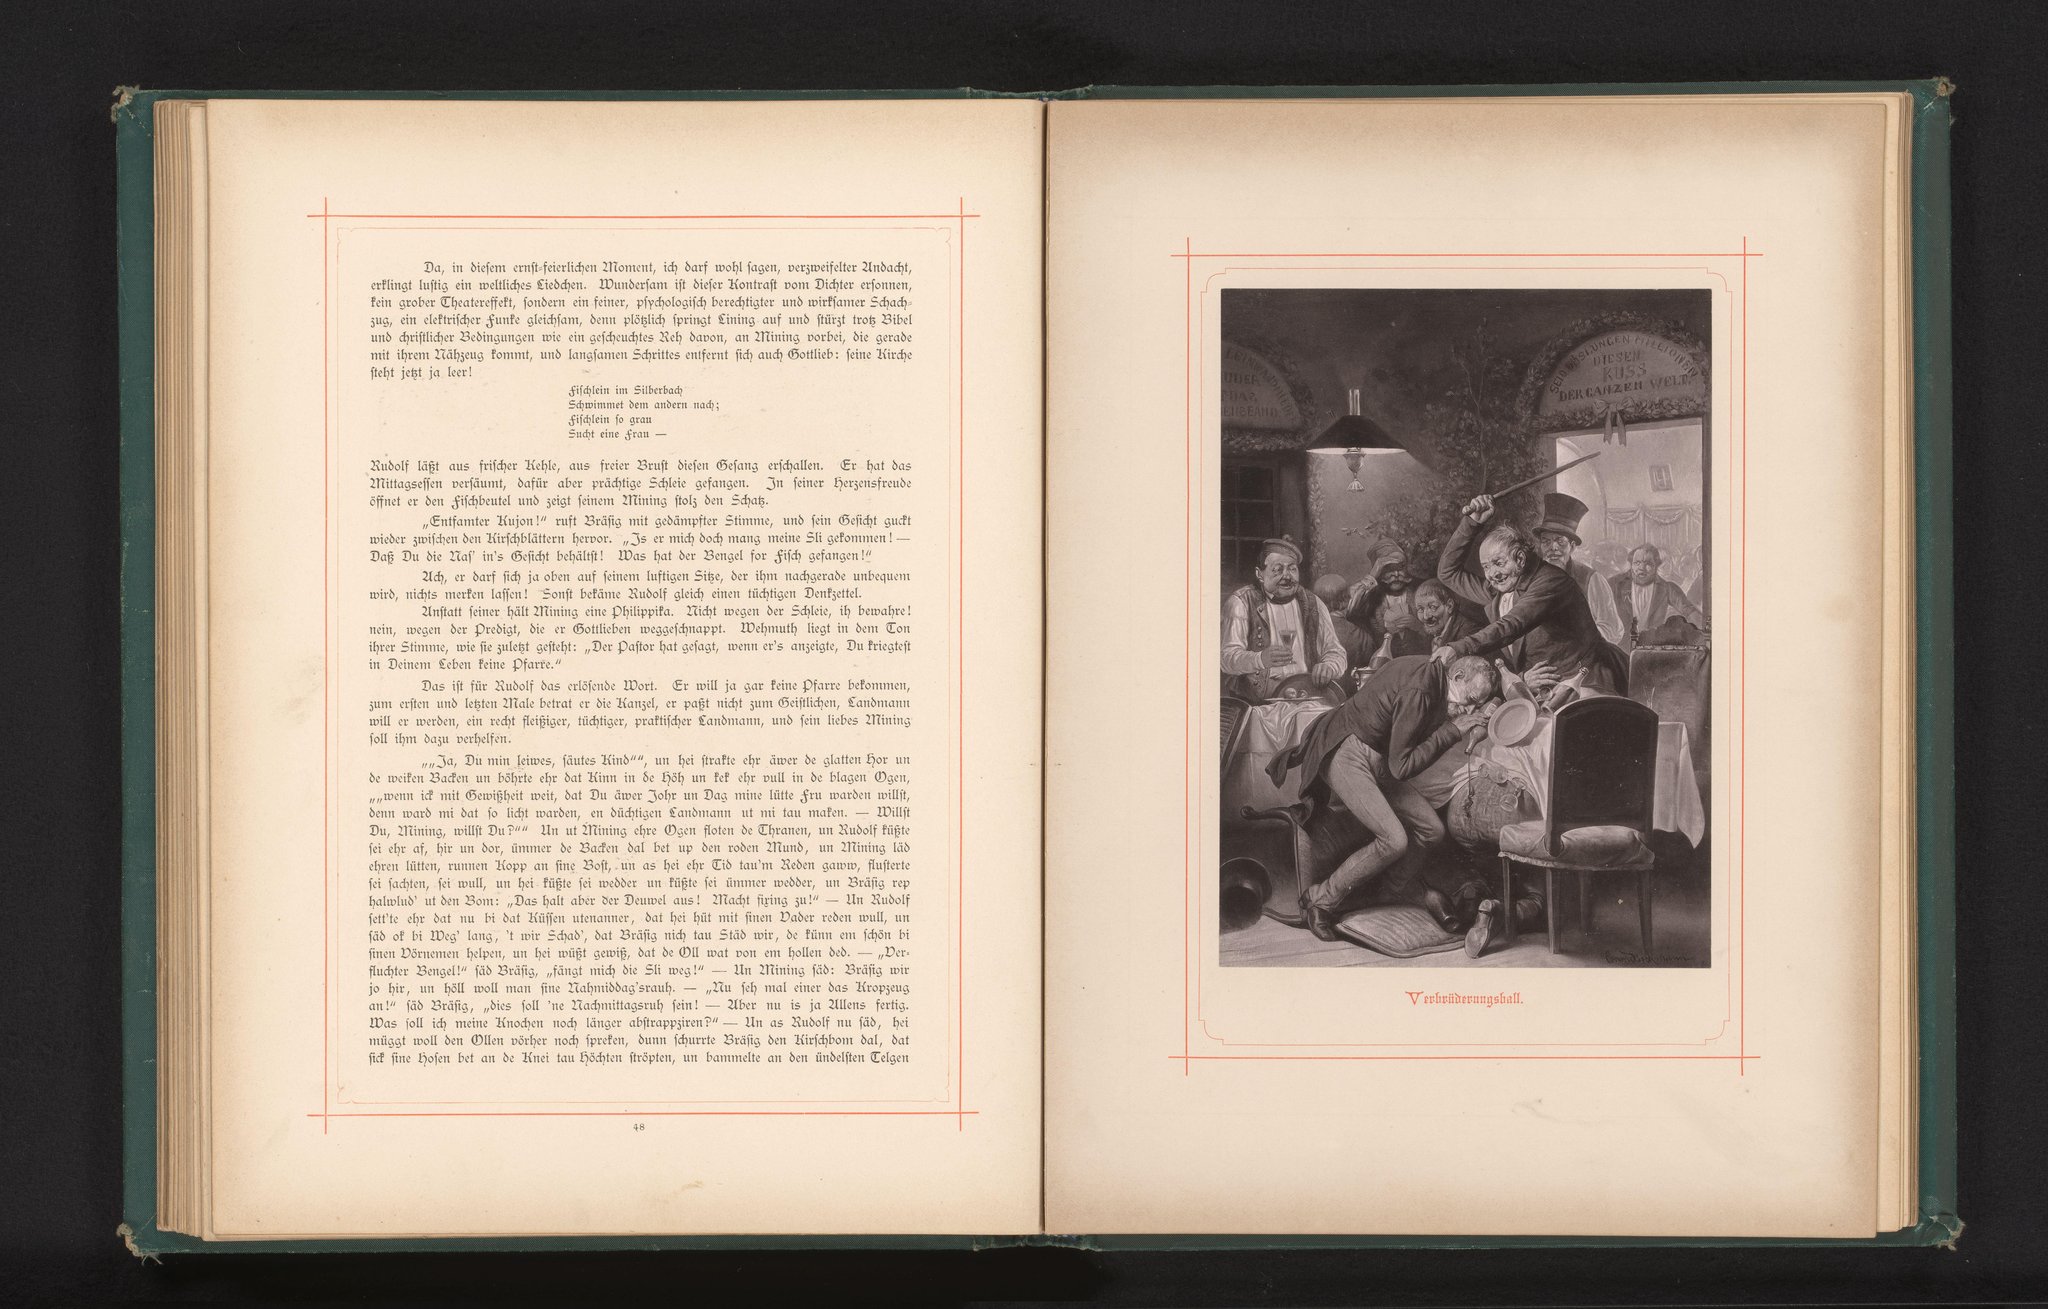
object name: page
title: Fotoreproductie van een schilderij van een groep mannen die drinken in een zaal, één van de mannen staat op het punt om een ander met een stok te slaan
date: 1874-1884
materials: paper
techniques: photograph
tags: picture, painting, drinking